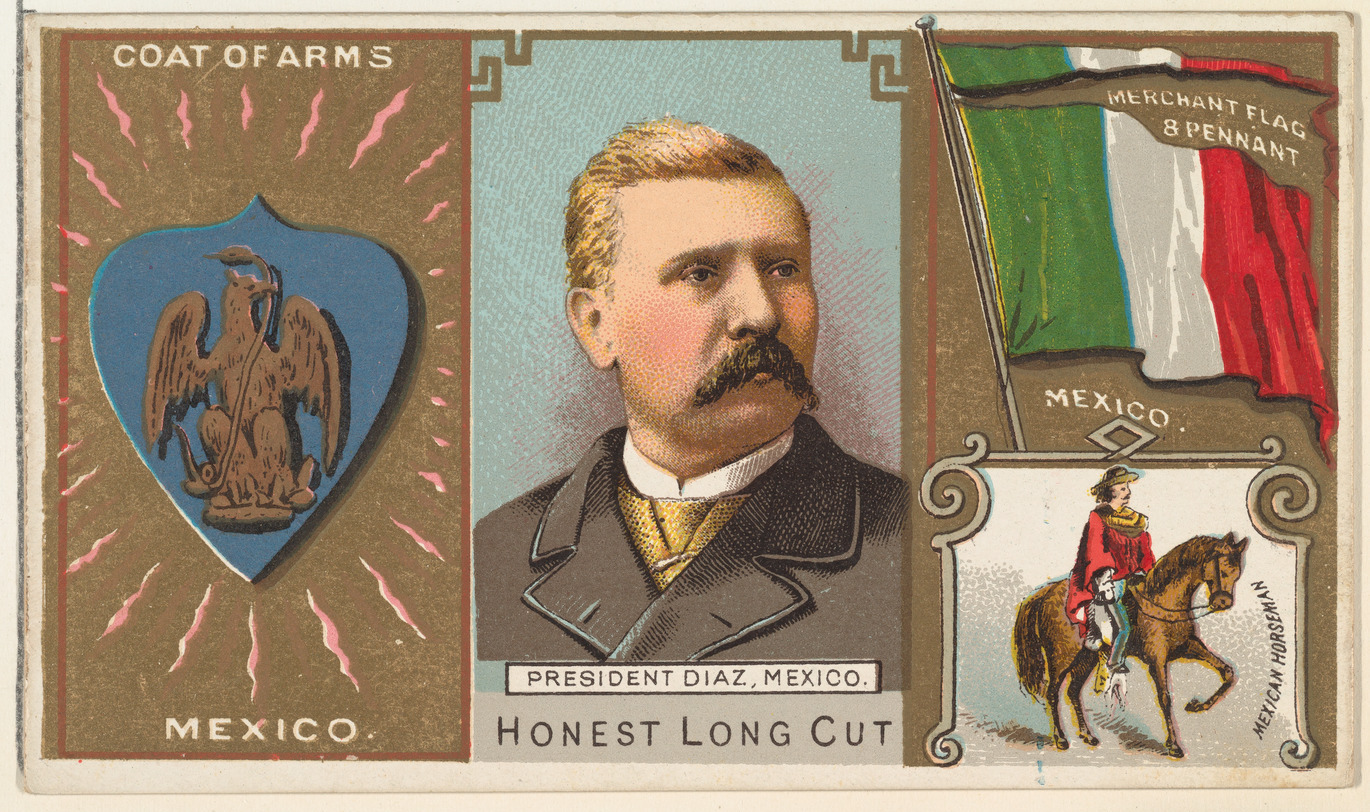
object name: print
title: President Diaz of Mexico, from the Rulers, Flags, and Coats of Arms series (N126-1) issued by W. Duke, Sons & Co.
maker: w. duke, sons & co.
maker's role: publisher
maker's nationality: american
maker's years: 1870-1920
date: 1888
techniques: color lithograph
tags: men,portraits,horses,coat of arms,flags